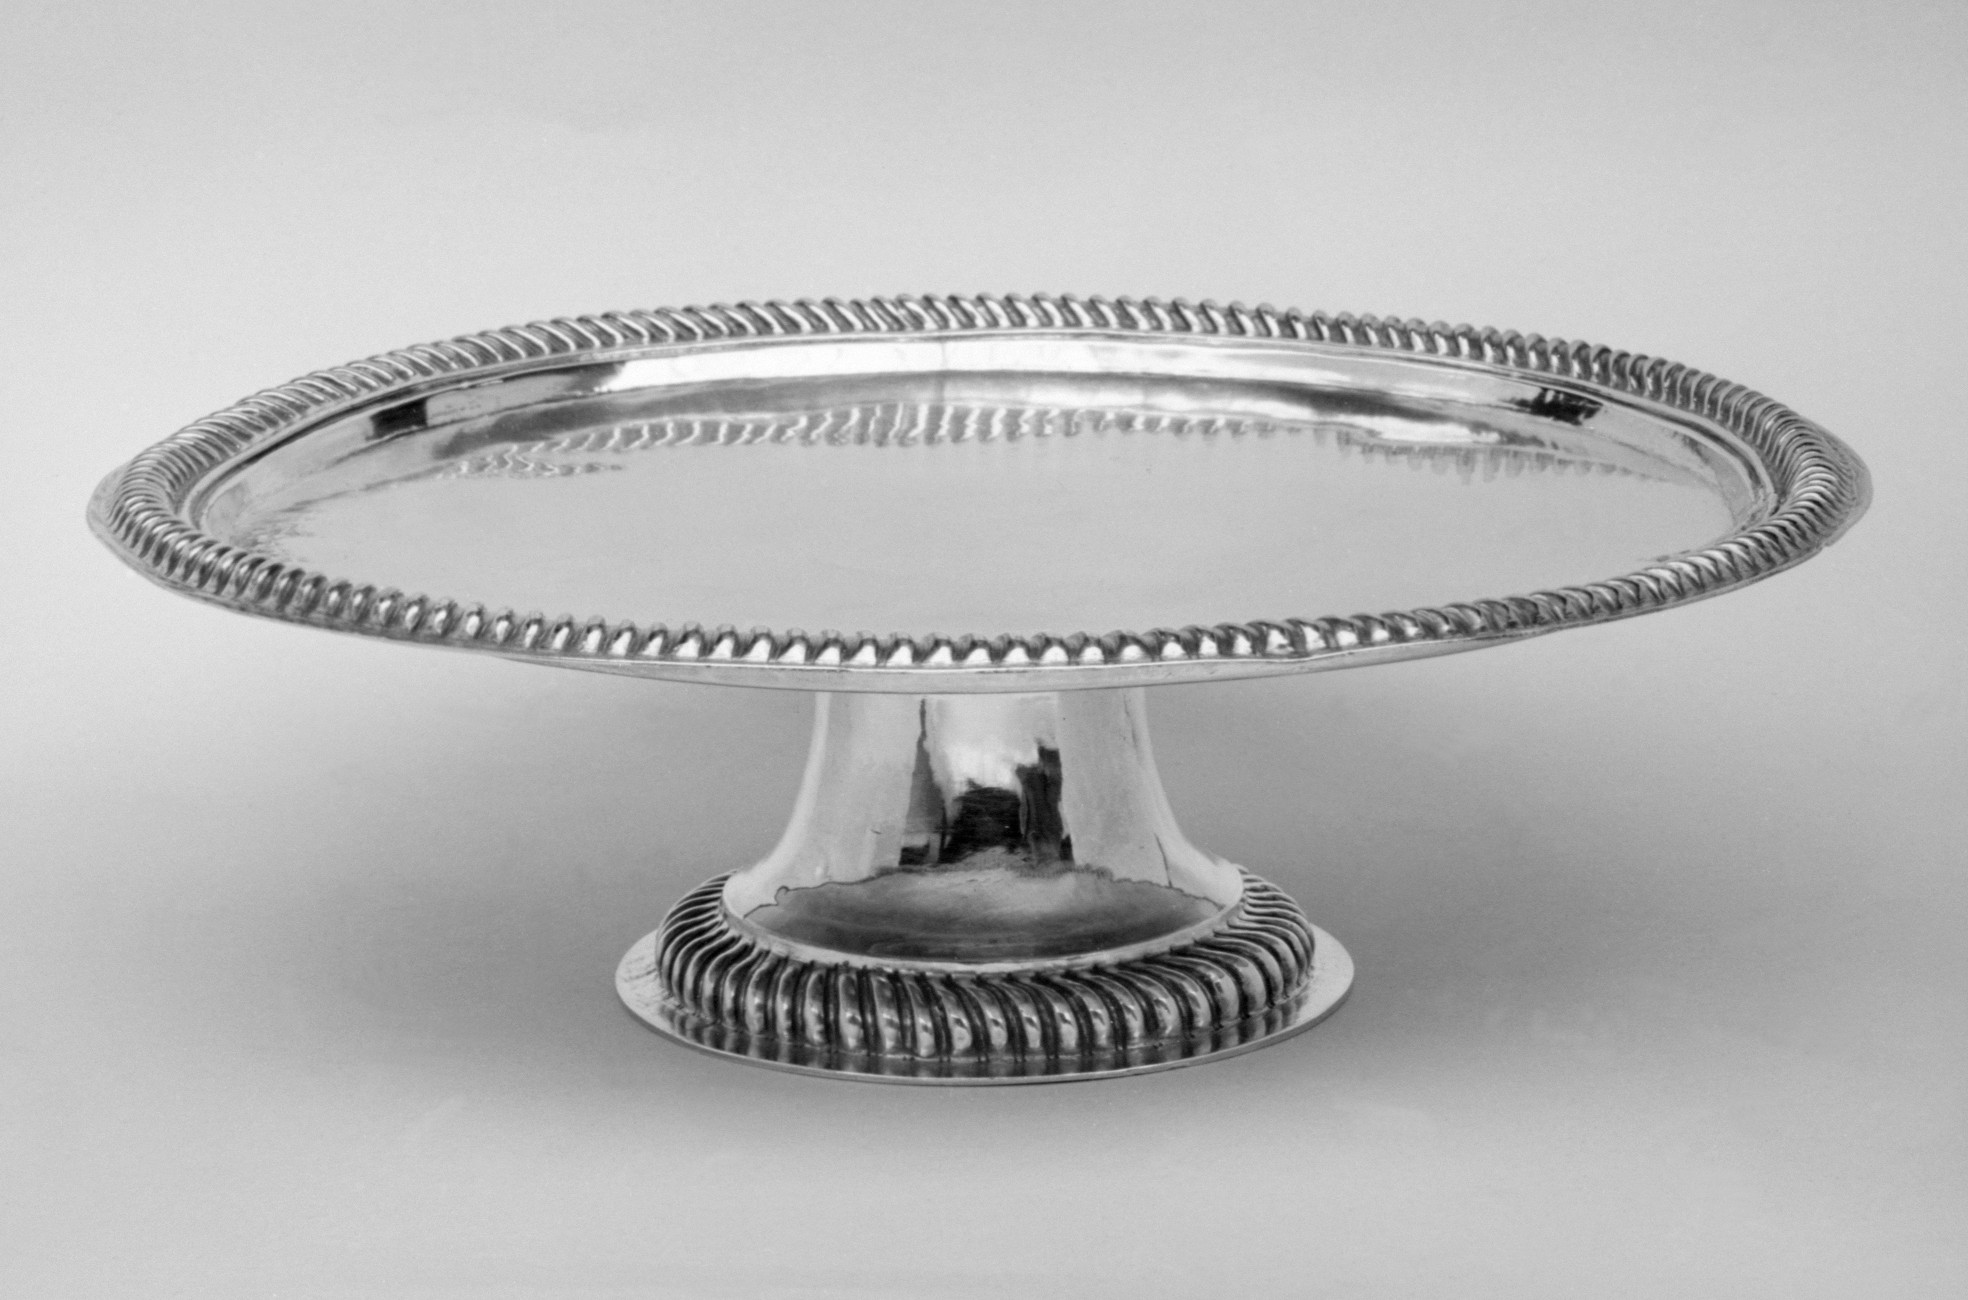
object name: tazza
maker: joseph ward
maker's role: maker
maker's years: 1689-1734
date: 1698-1699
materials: silver